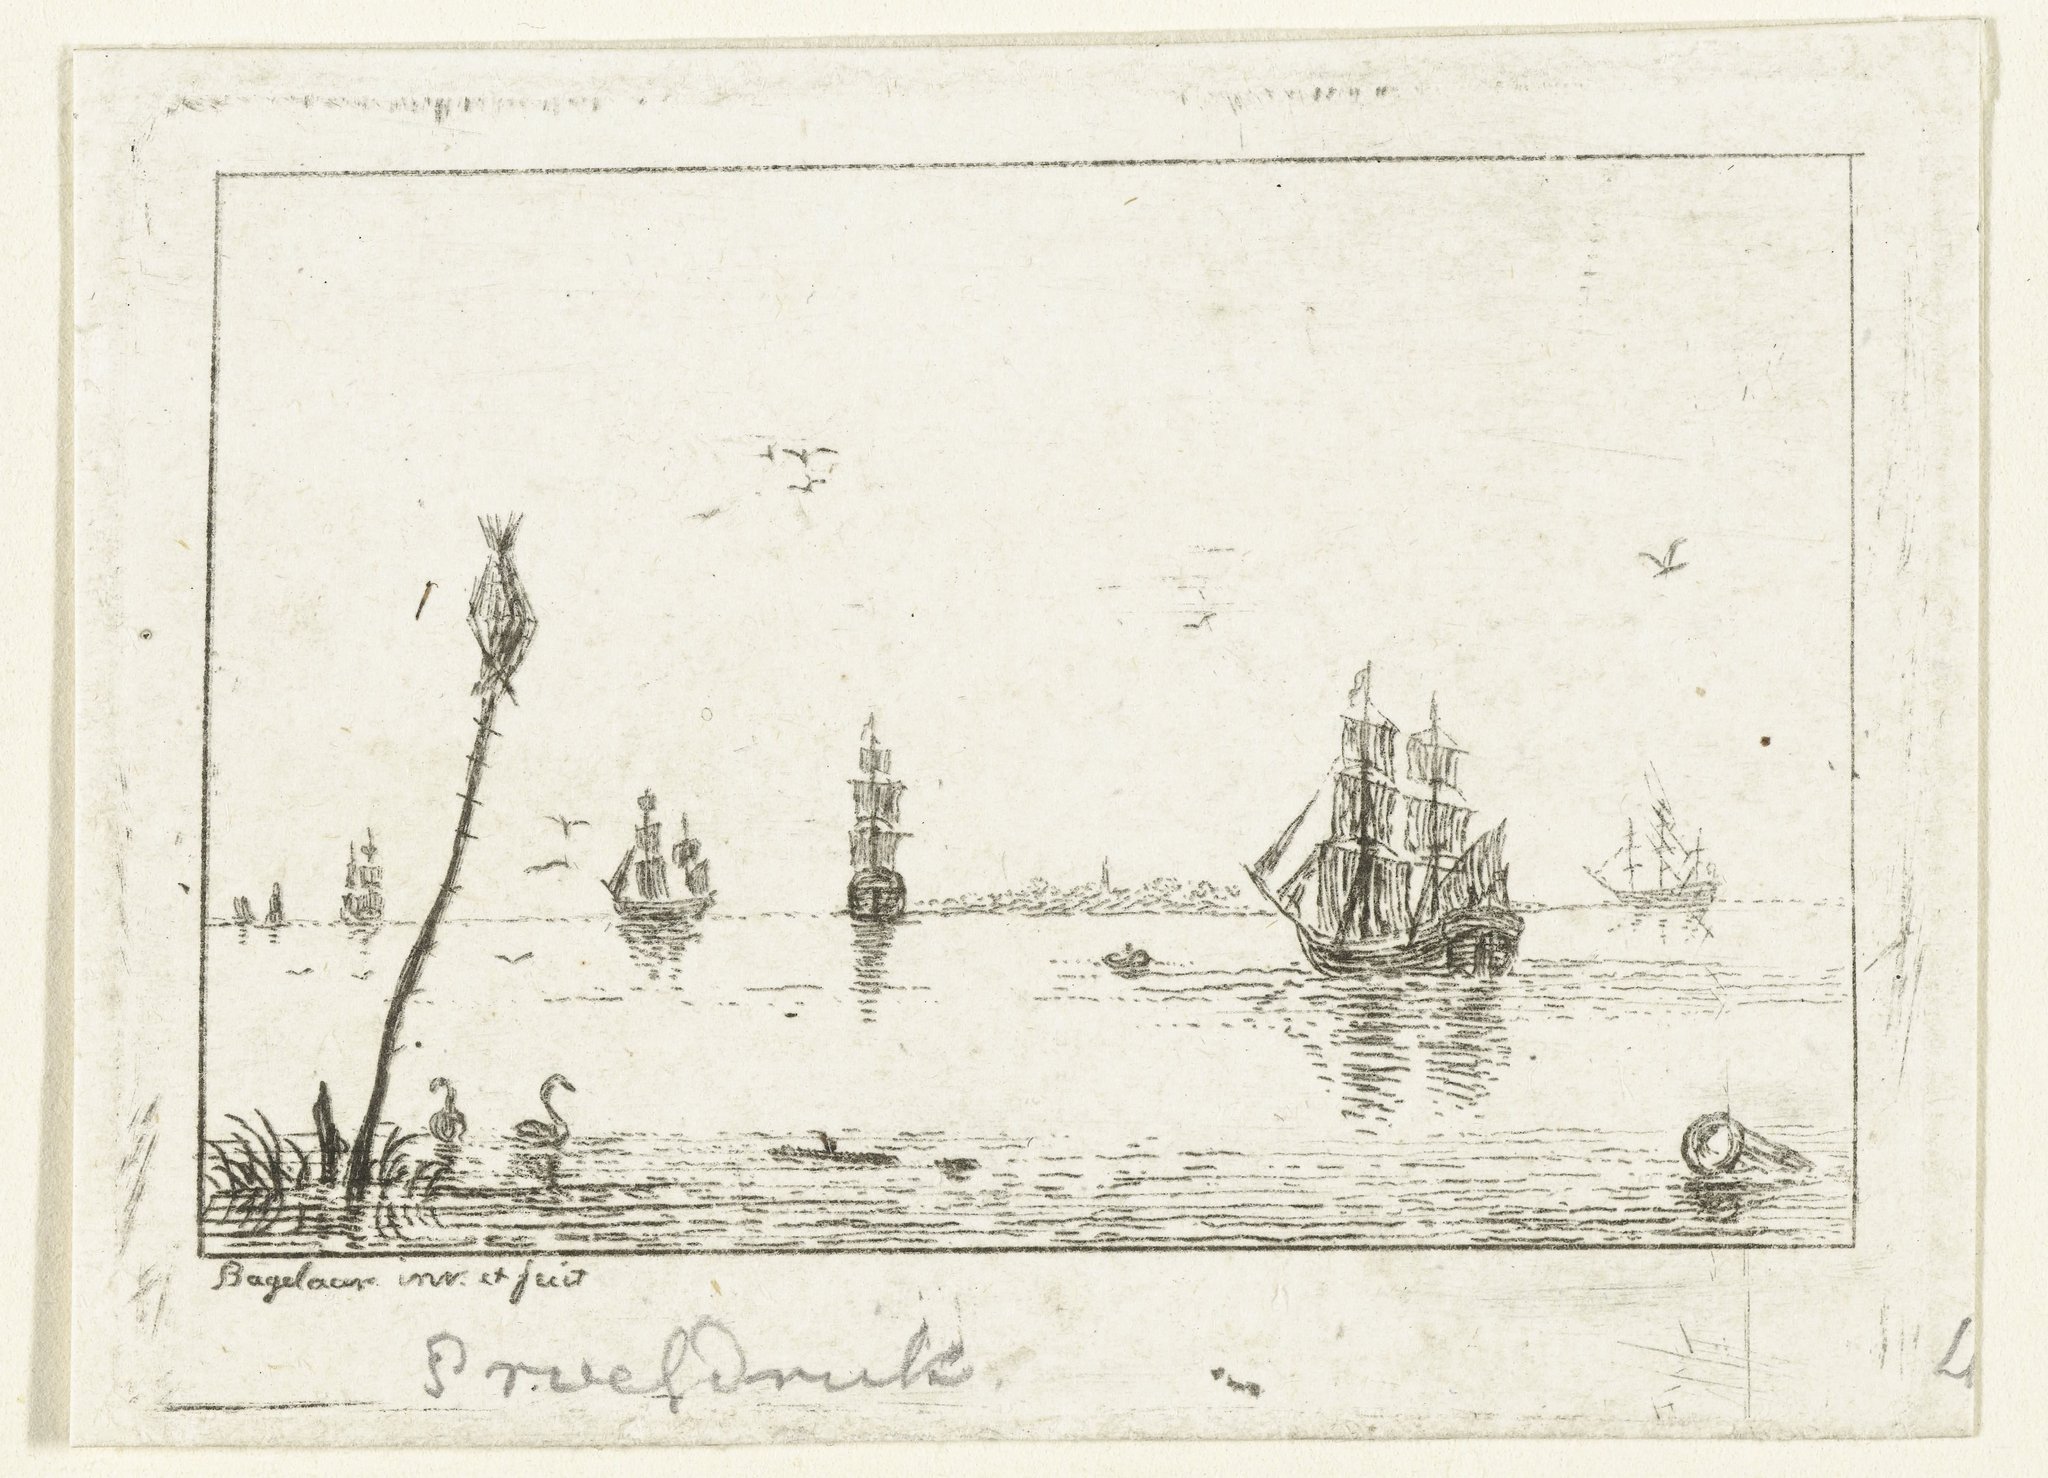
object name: print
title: Waterlandschap met zeilschepen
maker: ernst willem jan bagelaar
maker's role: draughtsman, print maker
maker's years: 1775-1837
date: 1798-1837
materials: paper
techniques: etching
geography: netherlands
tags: landscapes with waters, waterscapes, seascapes (in the temperate zone)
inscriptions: inscription: ‘Proefdruk’